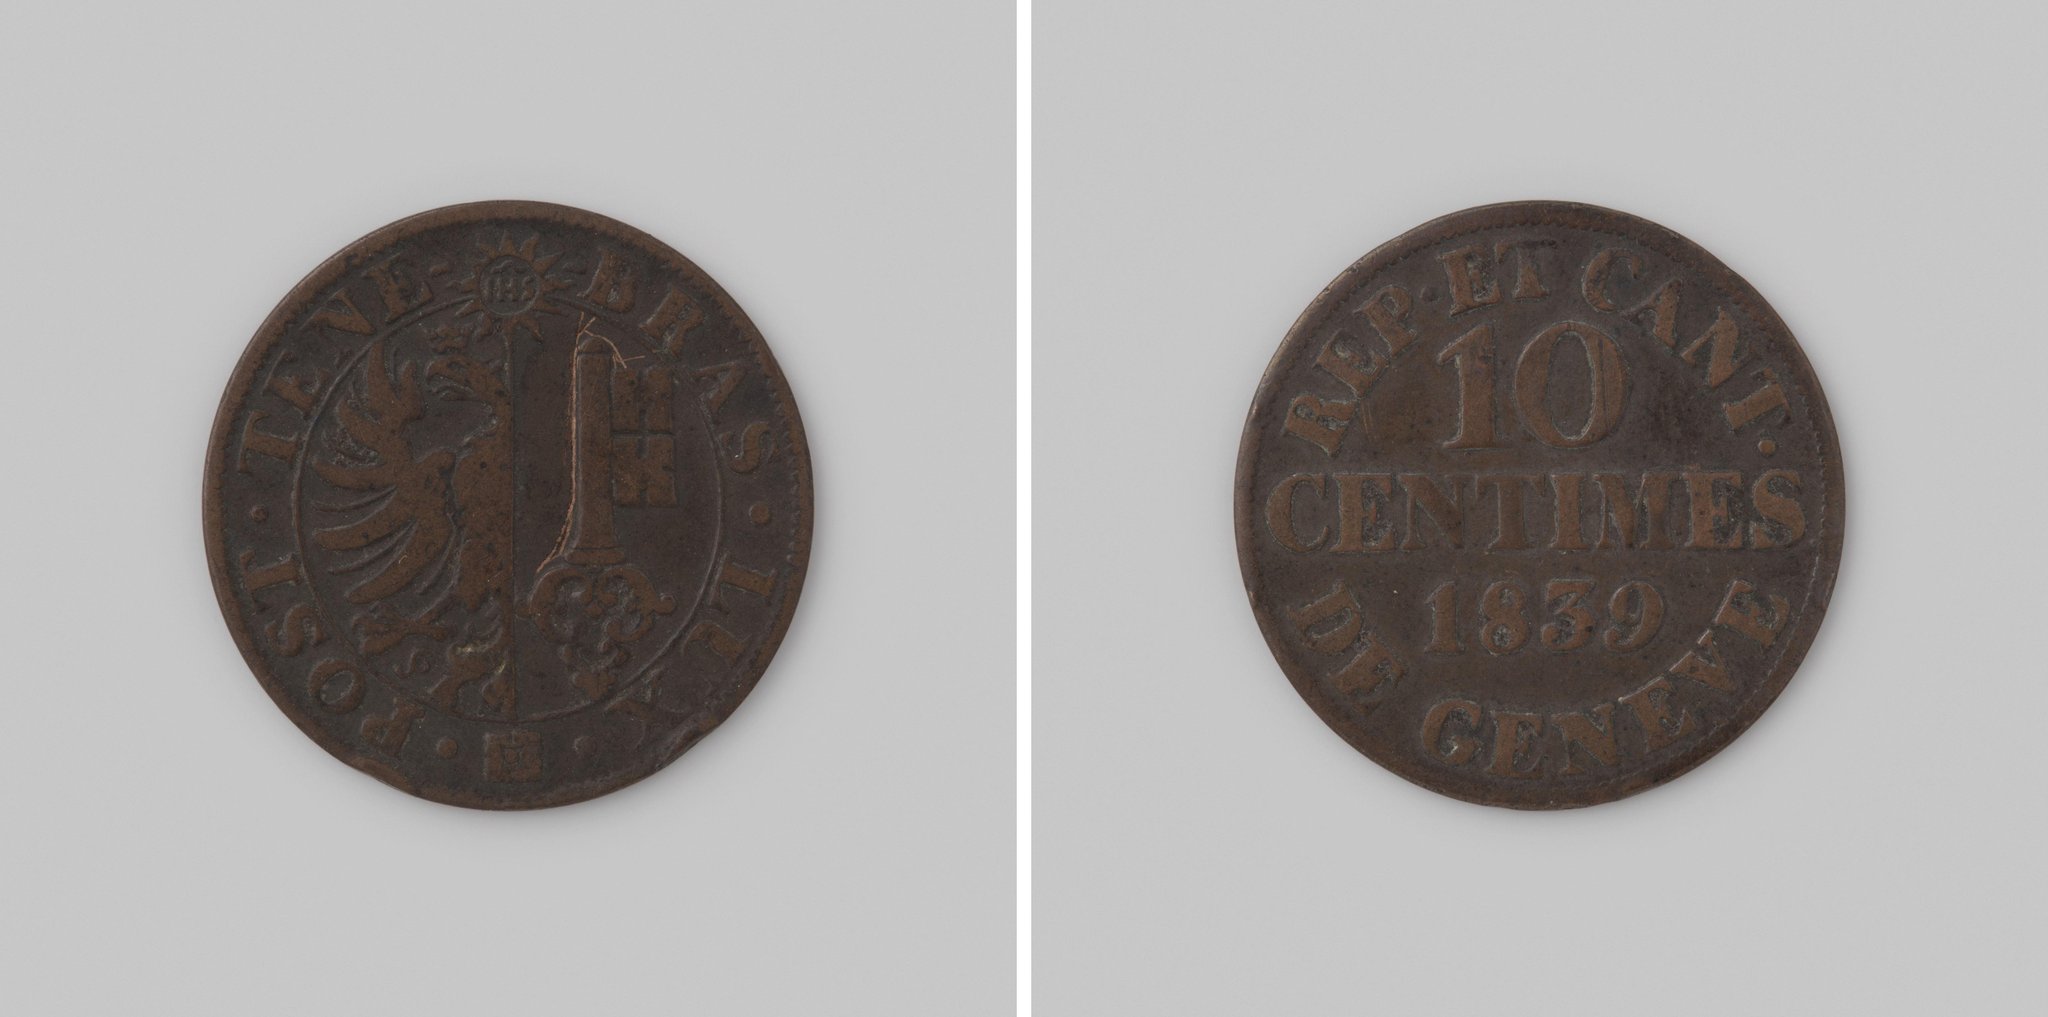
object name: tien centime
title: Kanton Geneve, 10 centimes, 1839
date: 1839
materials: copper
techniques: striking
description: Koperen munt. Voorzijde: wapen van Geneve in het veld. Daarboven binnen stralende zon de letters I,H en S. Keerzijde: waarde-aanduiding in twee regels, waaronder jaartal. Gladde rand.